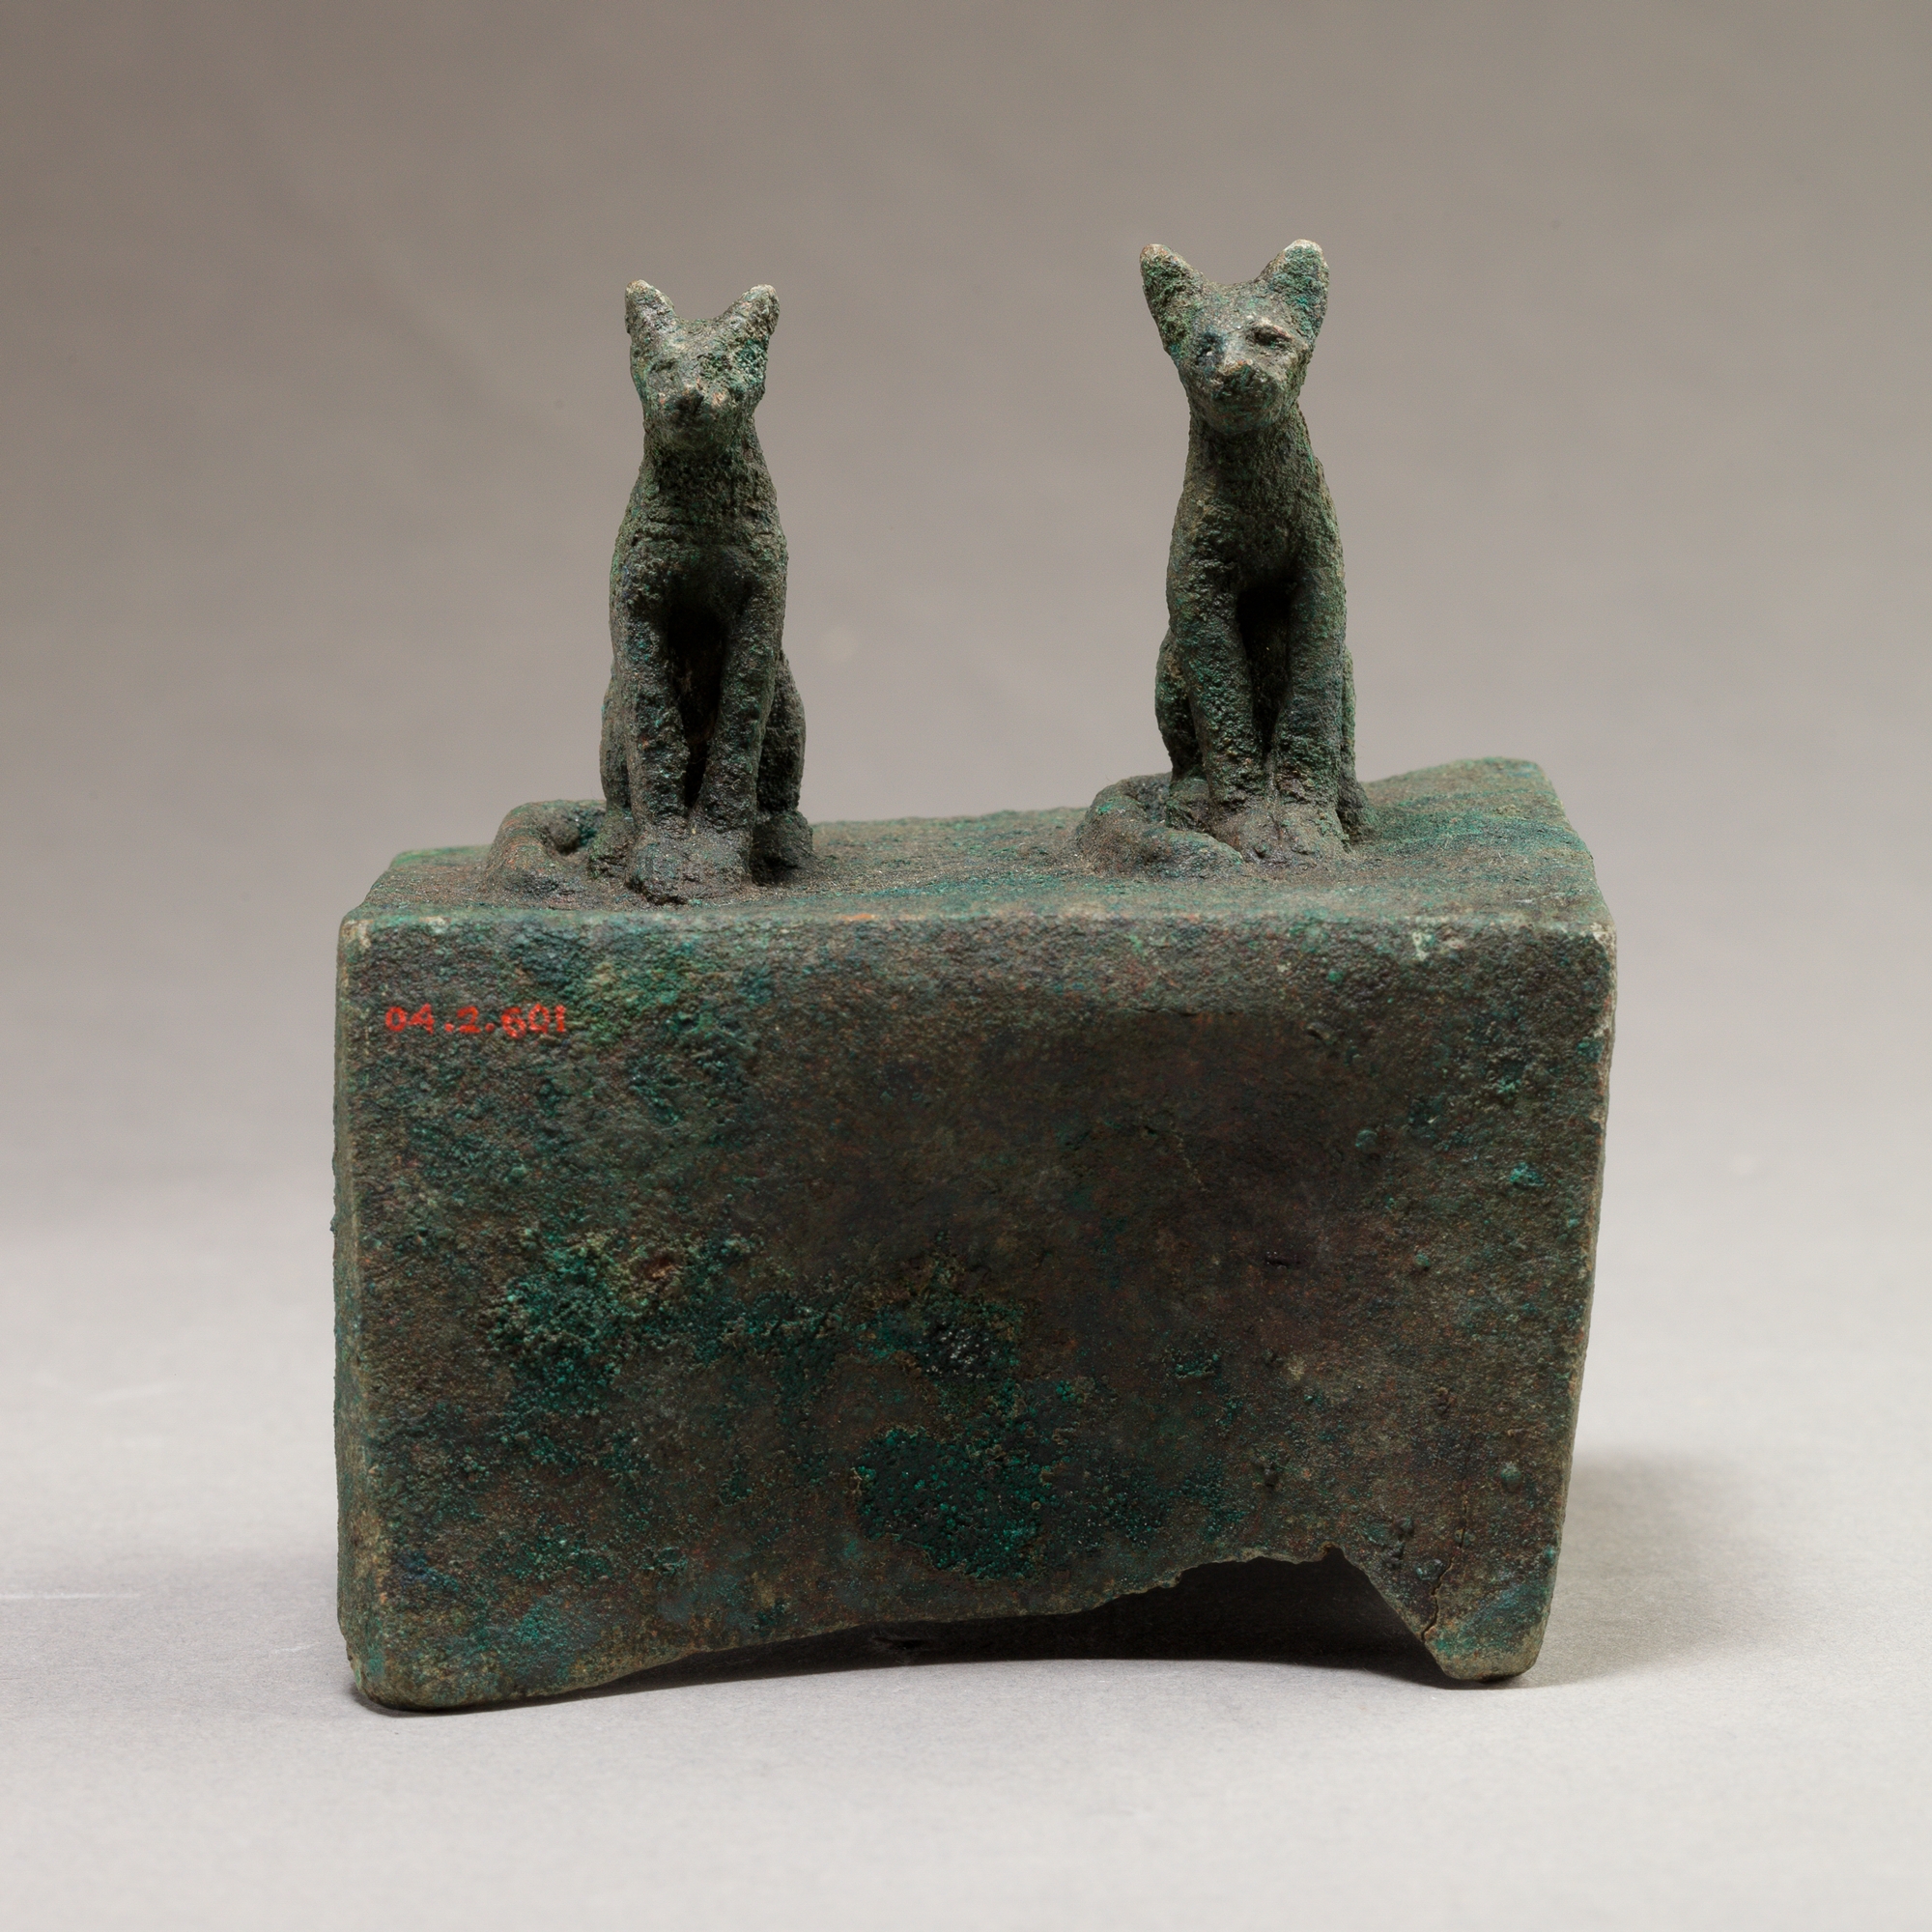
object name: coffin box, cat on box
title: Two cats surmounting a box for an animal mummy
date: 664-630 BCE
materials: metal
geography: egypt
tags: cats,coffins